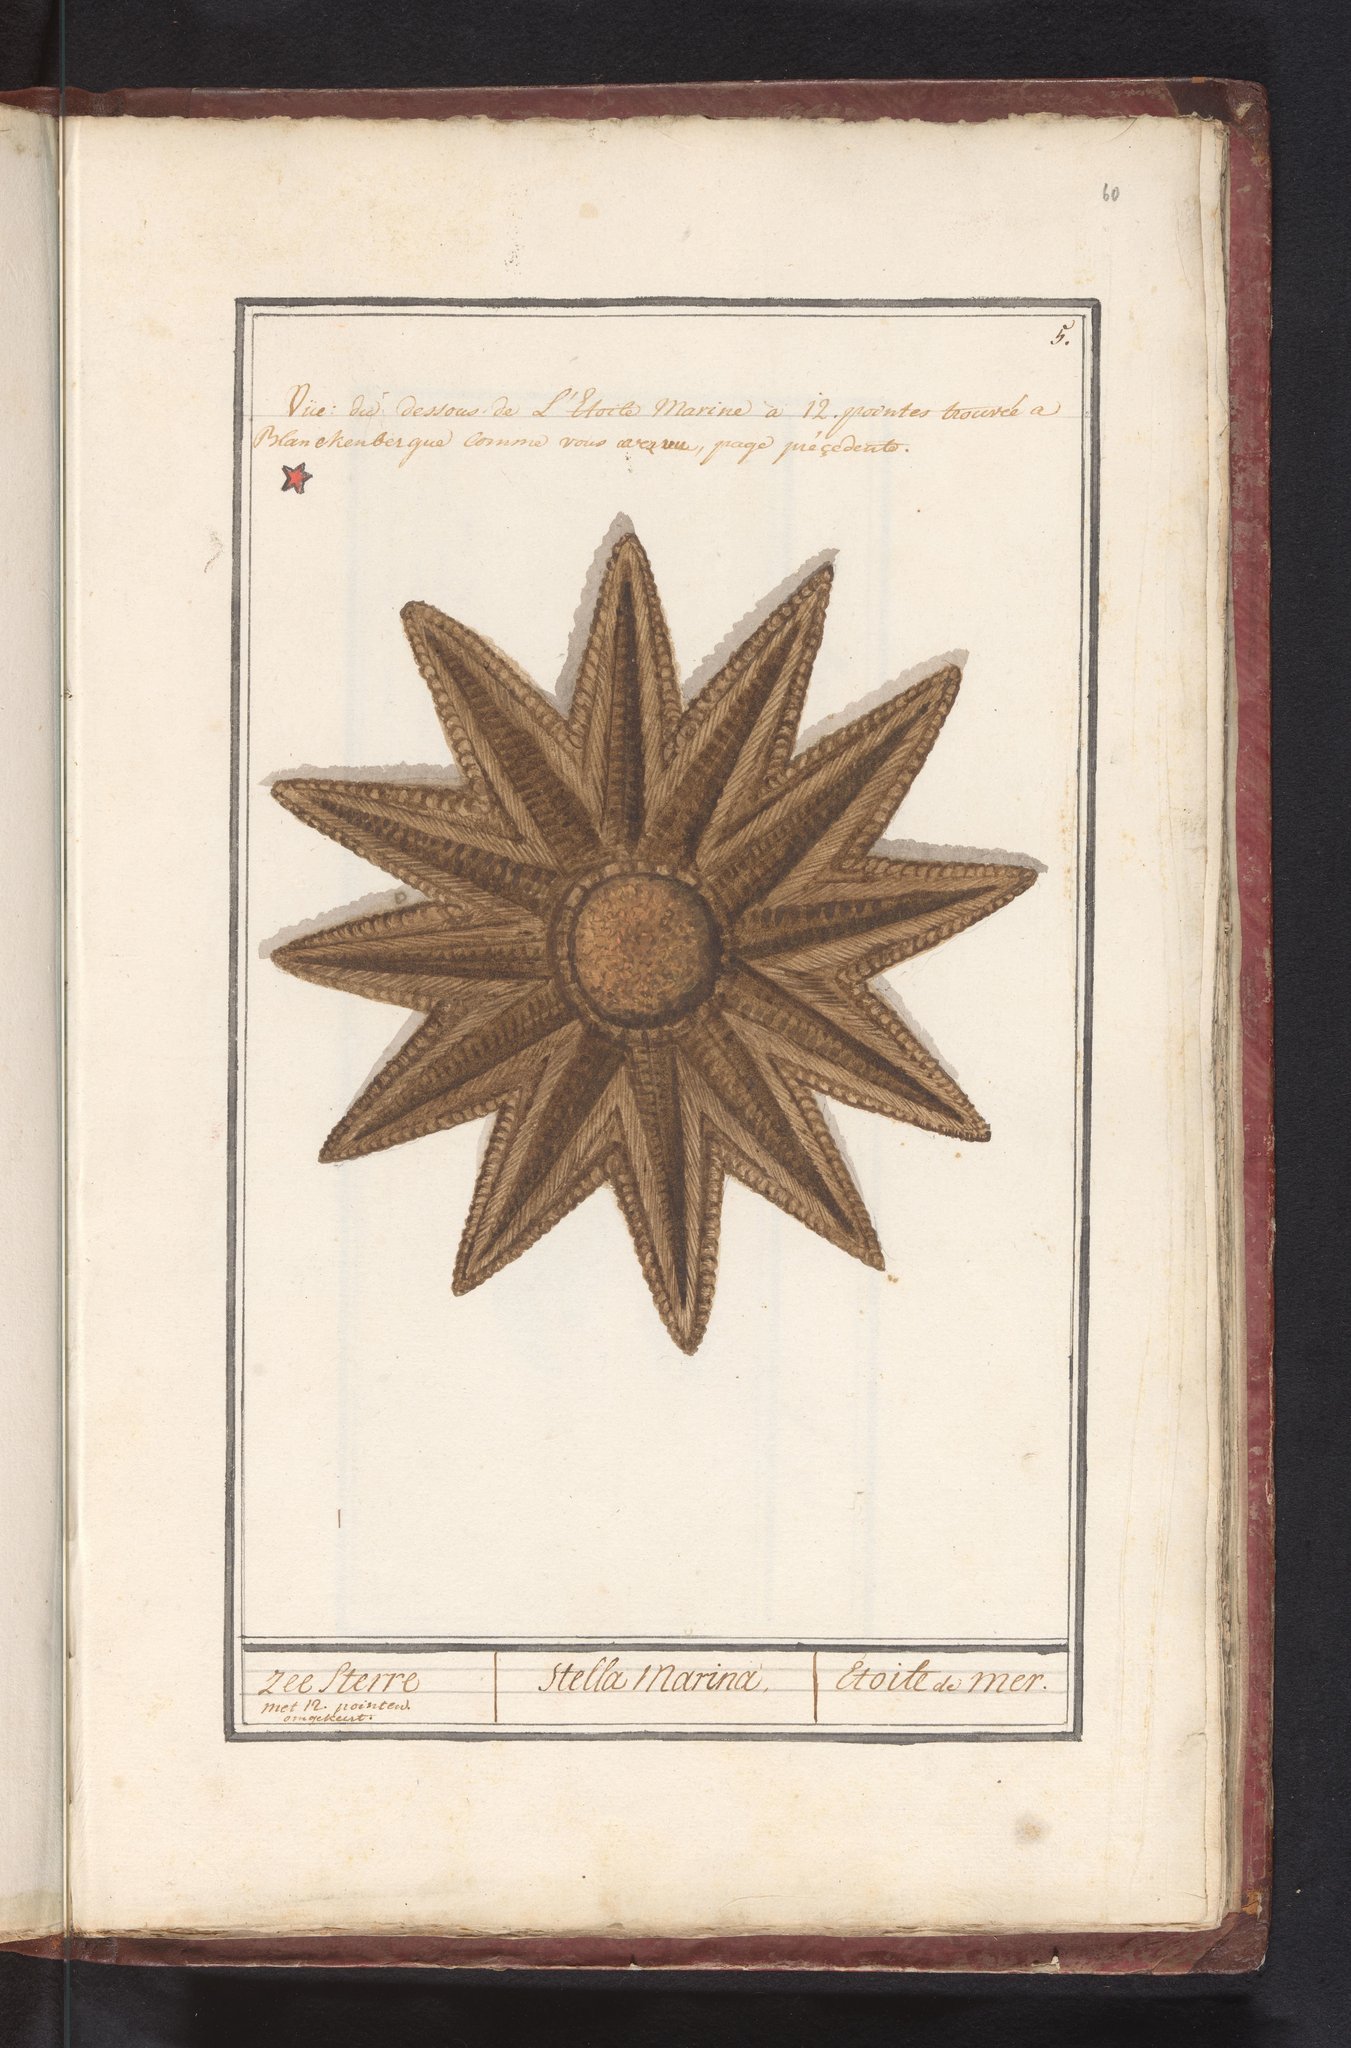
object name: drawing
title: Zee Sterre / Stella Marina / Etoile de Mer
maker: Anonymous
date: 1786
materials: chalk, paint, paper, pencil, watercolor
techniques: brush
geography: southern netherlands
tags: echinoderms: starfish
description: Zeester. Genummerd rechtsboven: 5. Linksboven gemerkt met een rode ster. Bovenaan een notitie over de vondst van deze zeester aan het strand van Blankenberge (in 1786). Onderdeel van het zesde album met tekeningen van vissen, schelpen en insekten. Zesde van twaalf albums met tekeningen van dieren, vogels en planten bekend rond 1600, gemaakt in opdracht van keizer Rudolf II. Met toelichting in Nederlands, Latijn en Frans.